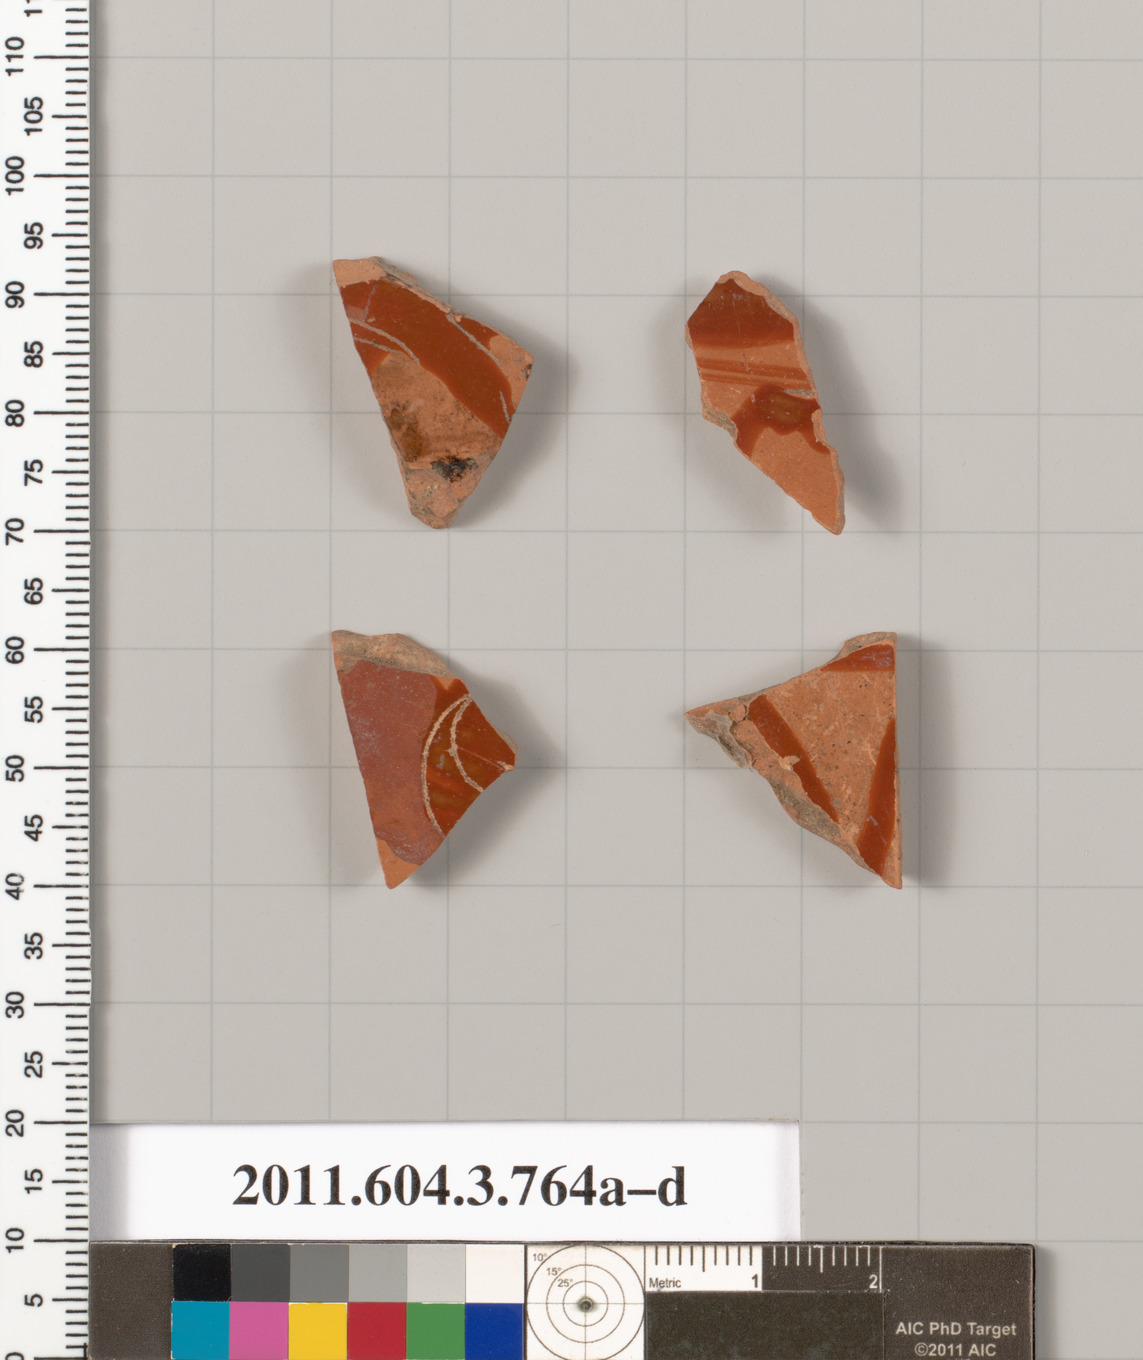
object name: neck amphora, tyrrhenian fragment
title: Terracotta fragments of a neck-amphora (jar)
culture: greek, attic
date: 575-551 BCE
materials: terracotta